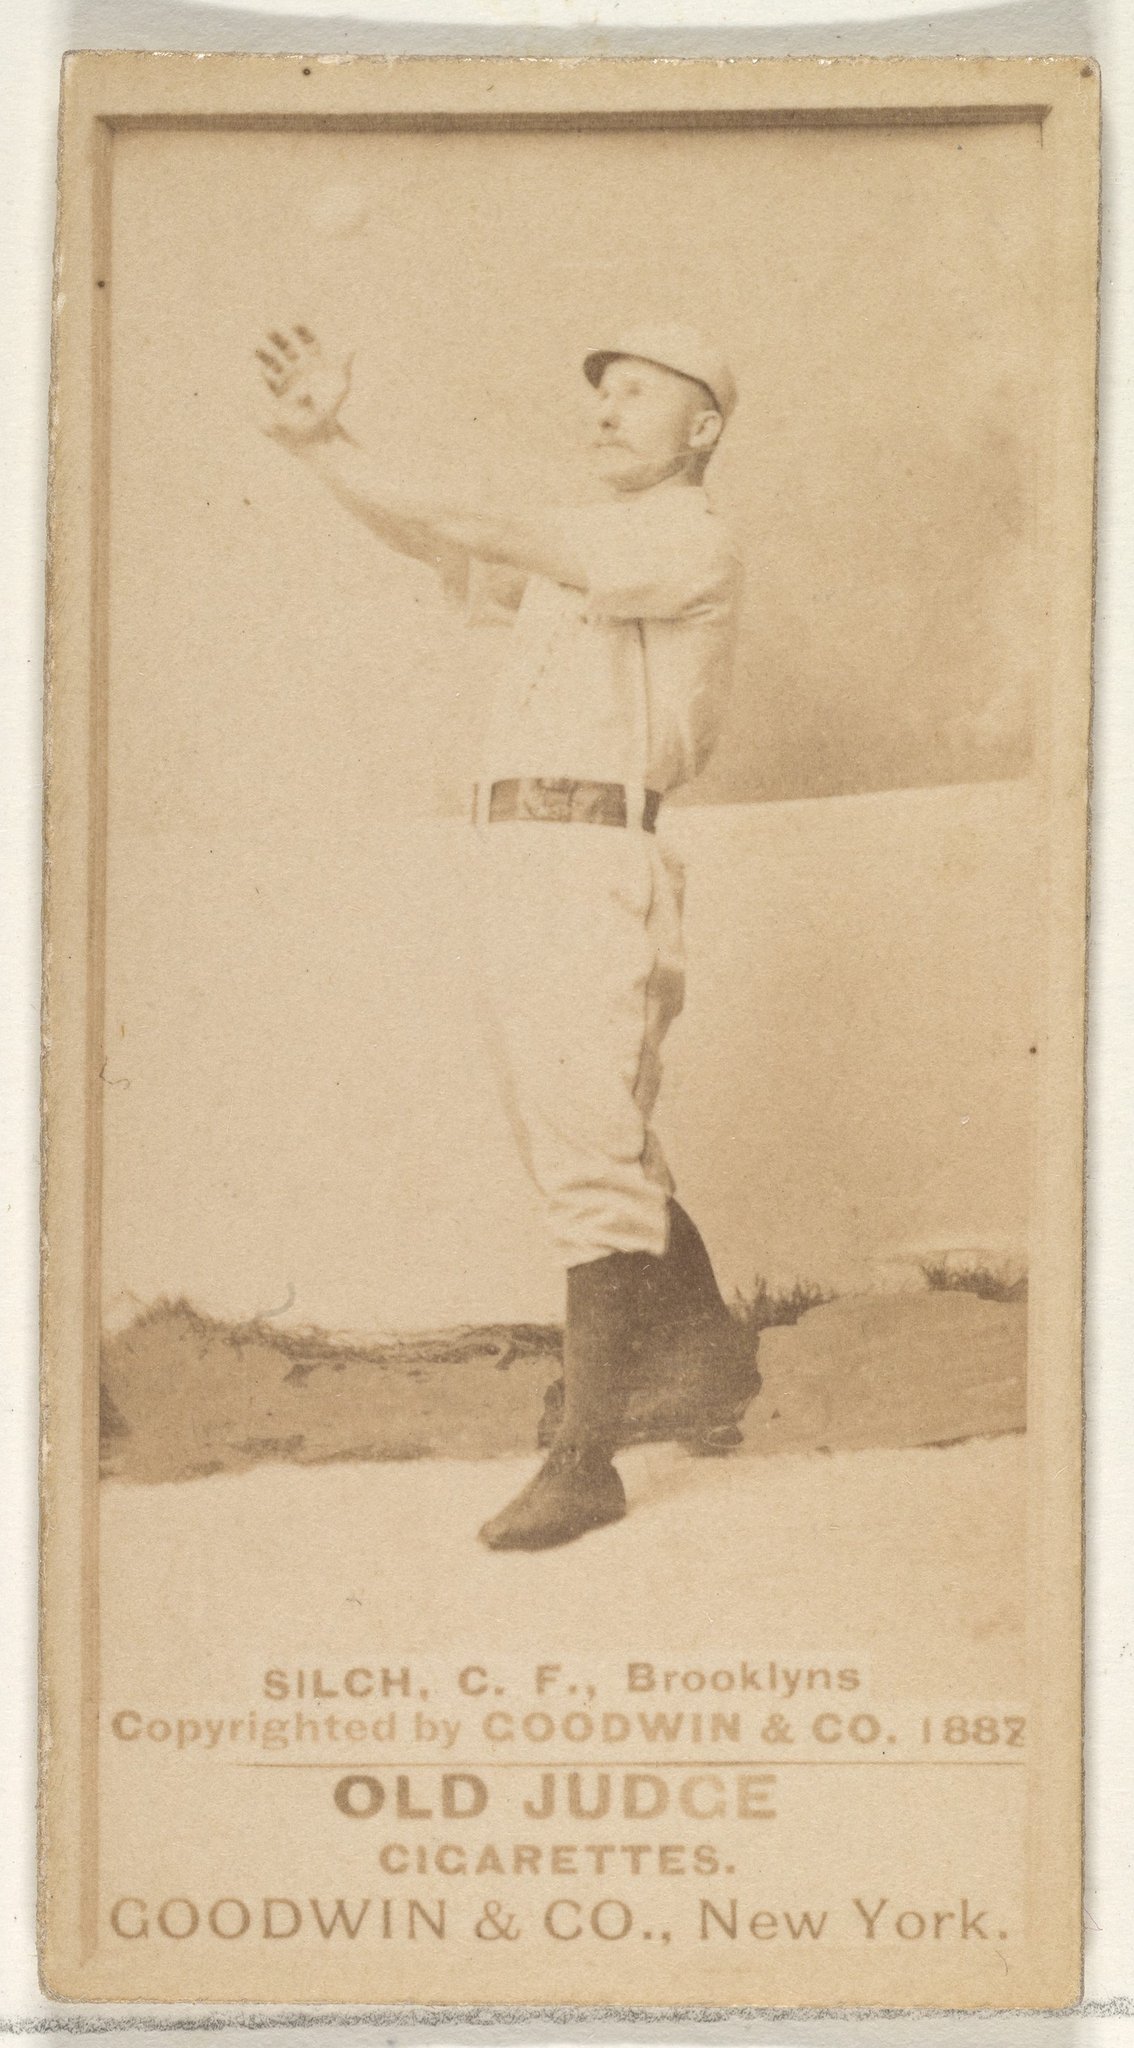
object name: baseball card, photograph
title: Silch, Center Field, Brooklyn Bridegrooms, from the Old Judge series (N172) for Old Judge Cigarettes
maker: goodwin & company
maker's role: publisher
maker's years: 1850-1950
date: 1887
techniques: albumen silver print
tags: men,portraits,baseball,athletes